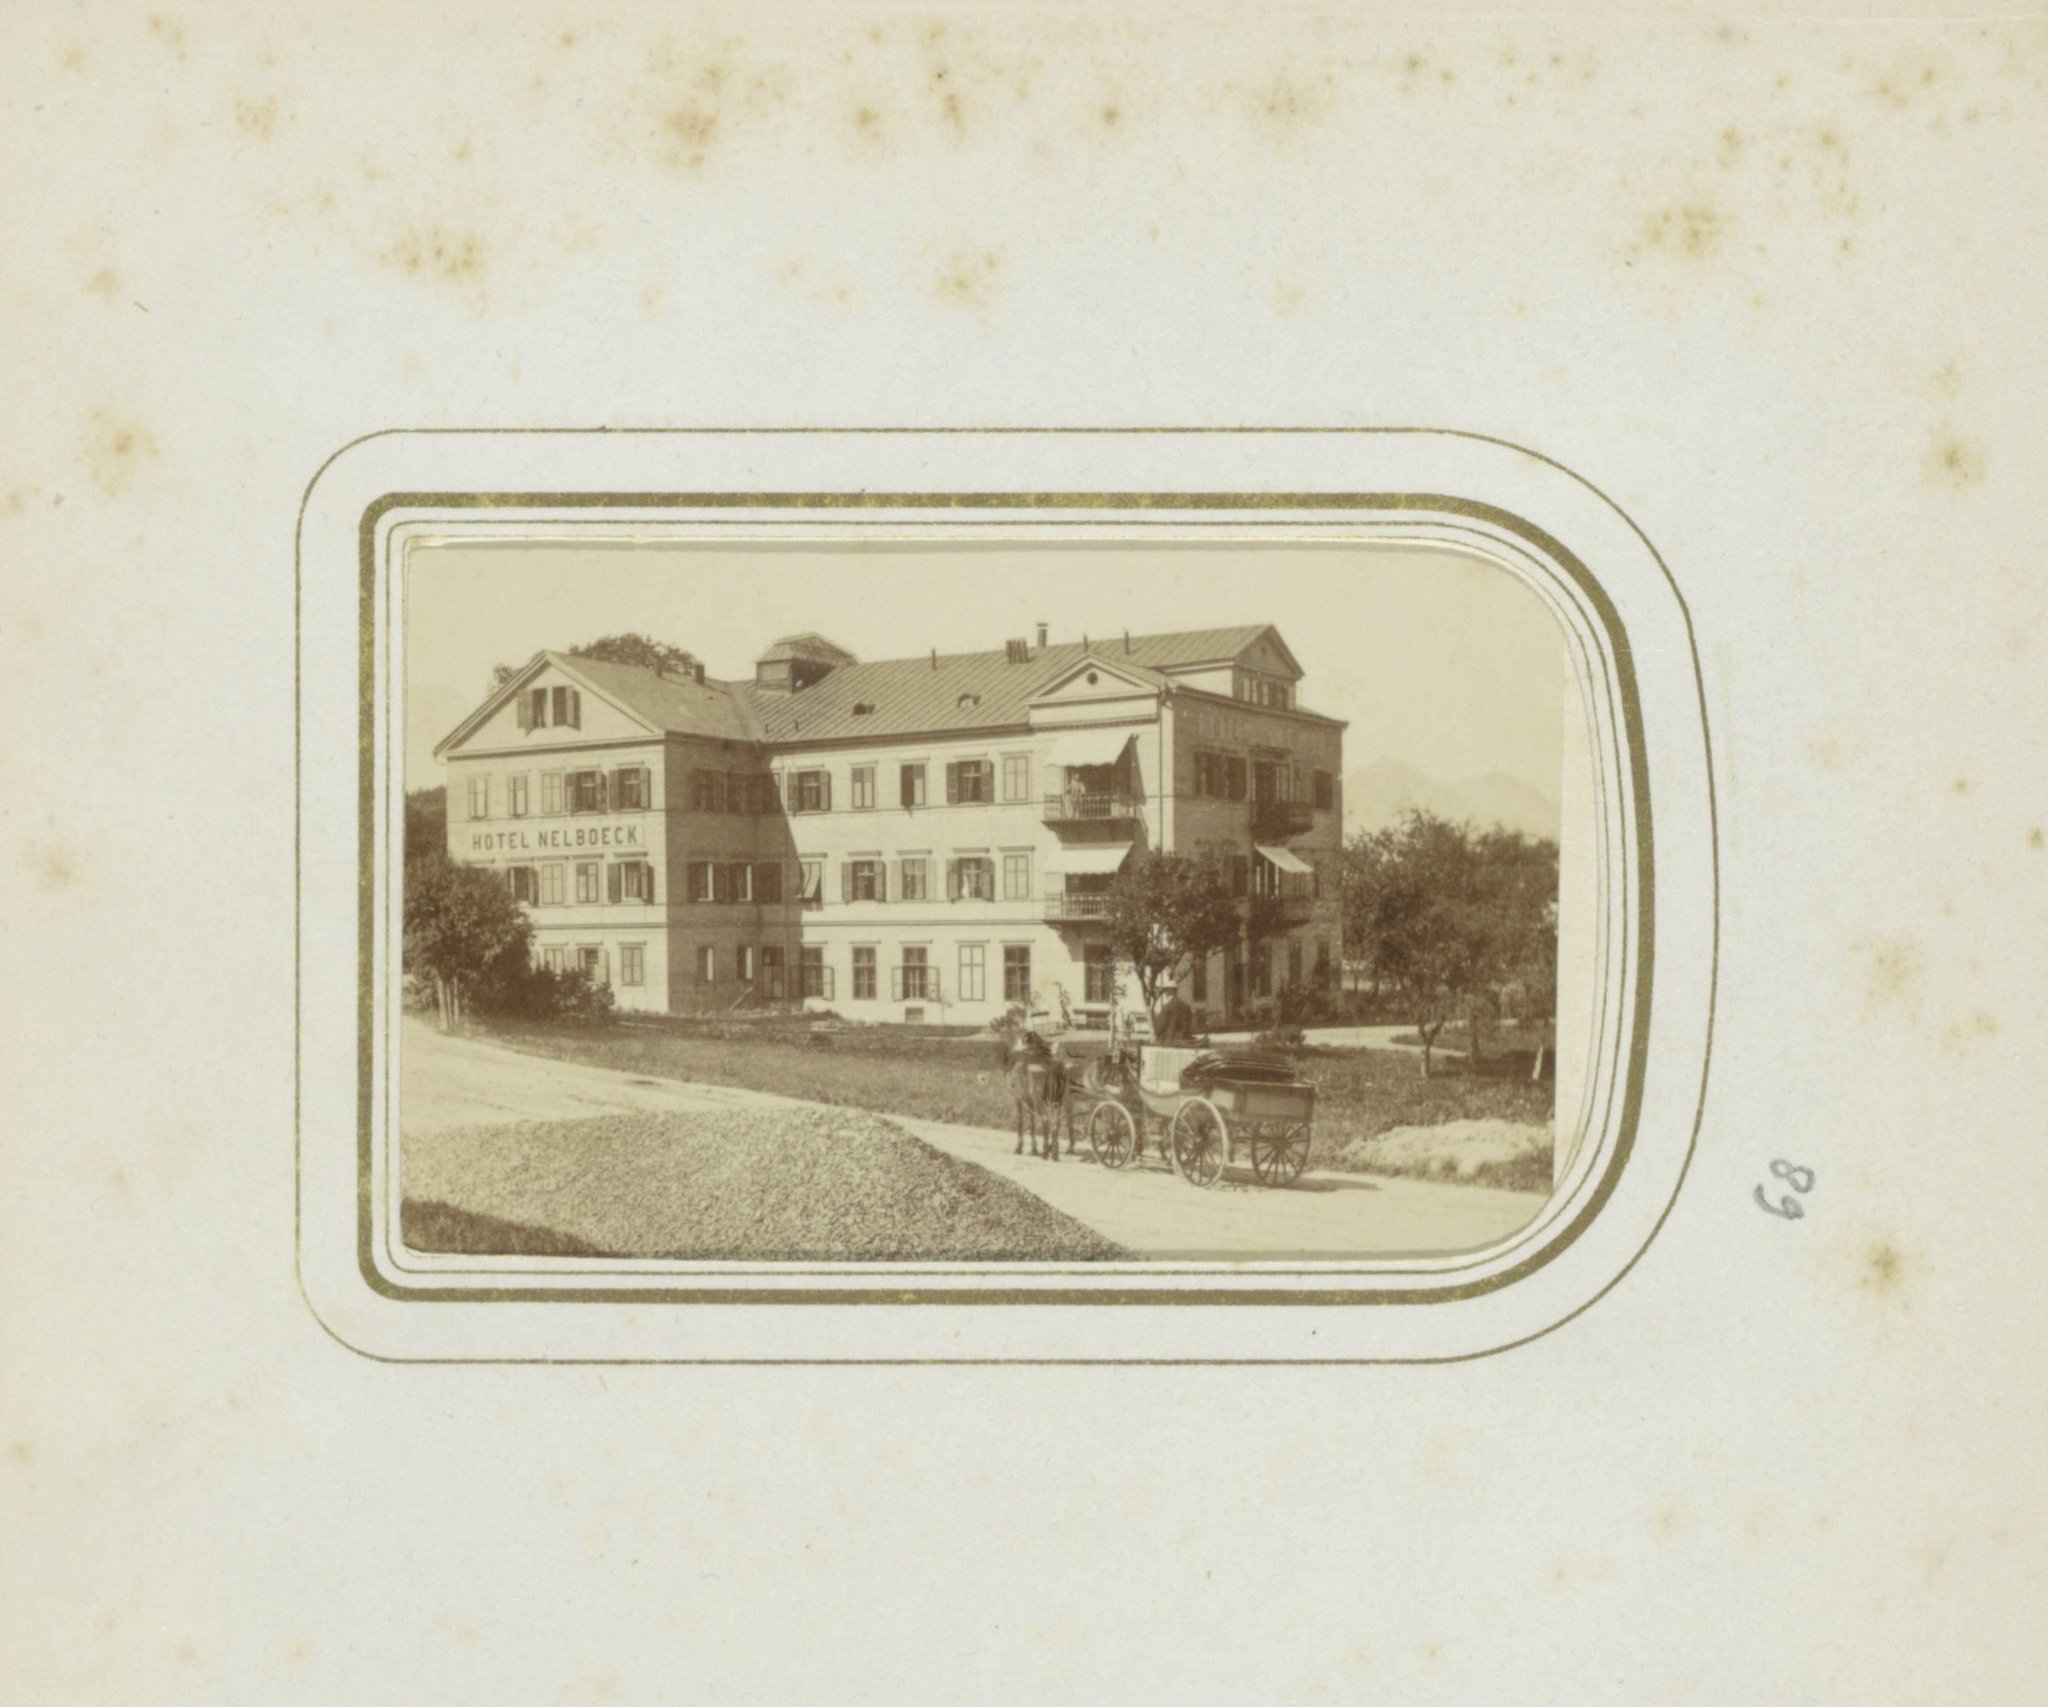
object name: photograph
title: Exterieur van Hotel Nelboeck in Salzburg met een paardenkoets ervoor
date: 1865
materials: paper, photographic support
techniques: albumen print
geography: drievuldigheidskerk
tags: four-wheeled, animal-drawn vehicle, e.g.: cab, carriage, coach (+ conveyance for transport of persons), river, waterfall, church (exterior), travelling; tourism, parts of church exterior and annexes: tower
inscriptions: address: ‘Salzburg Riedenburg, Villa Baldi, No. 17’, name: ‘Baldi & Würthle Photographische Anstalt’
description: Onderdeel van Fotoalbum van een reis door Zwitserland, Oostenrijk en Duitsland door de Nederlandse familie Derkinderen.